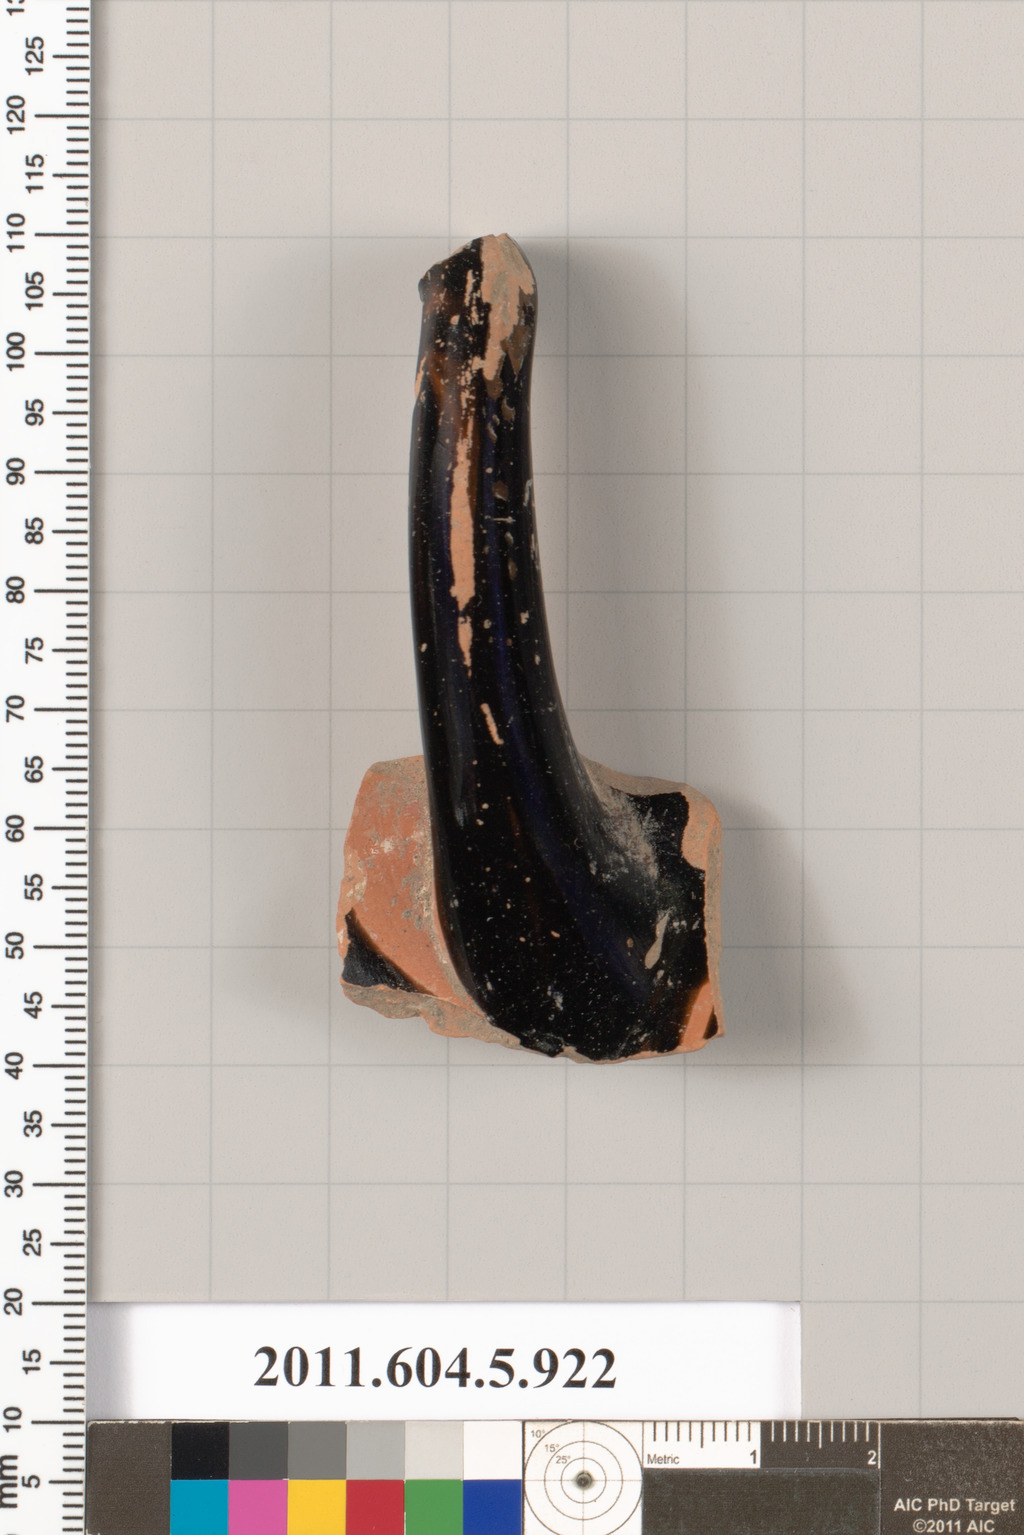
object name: kylix fragment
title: Terracotta fragment of a kylix (drinking cup)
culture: greek, attic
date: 600-401 BCE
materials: terracotta